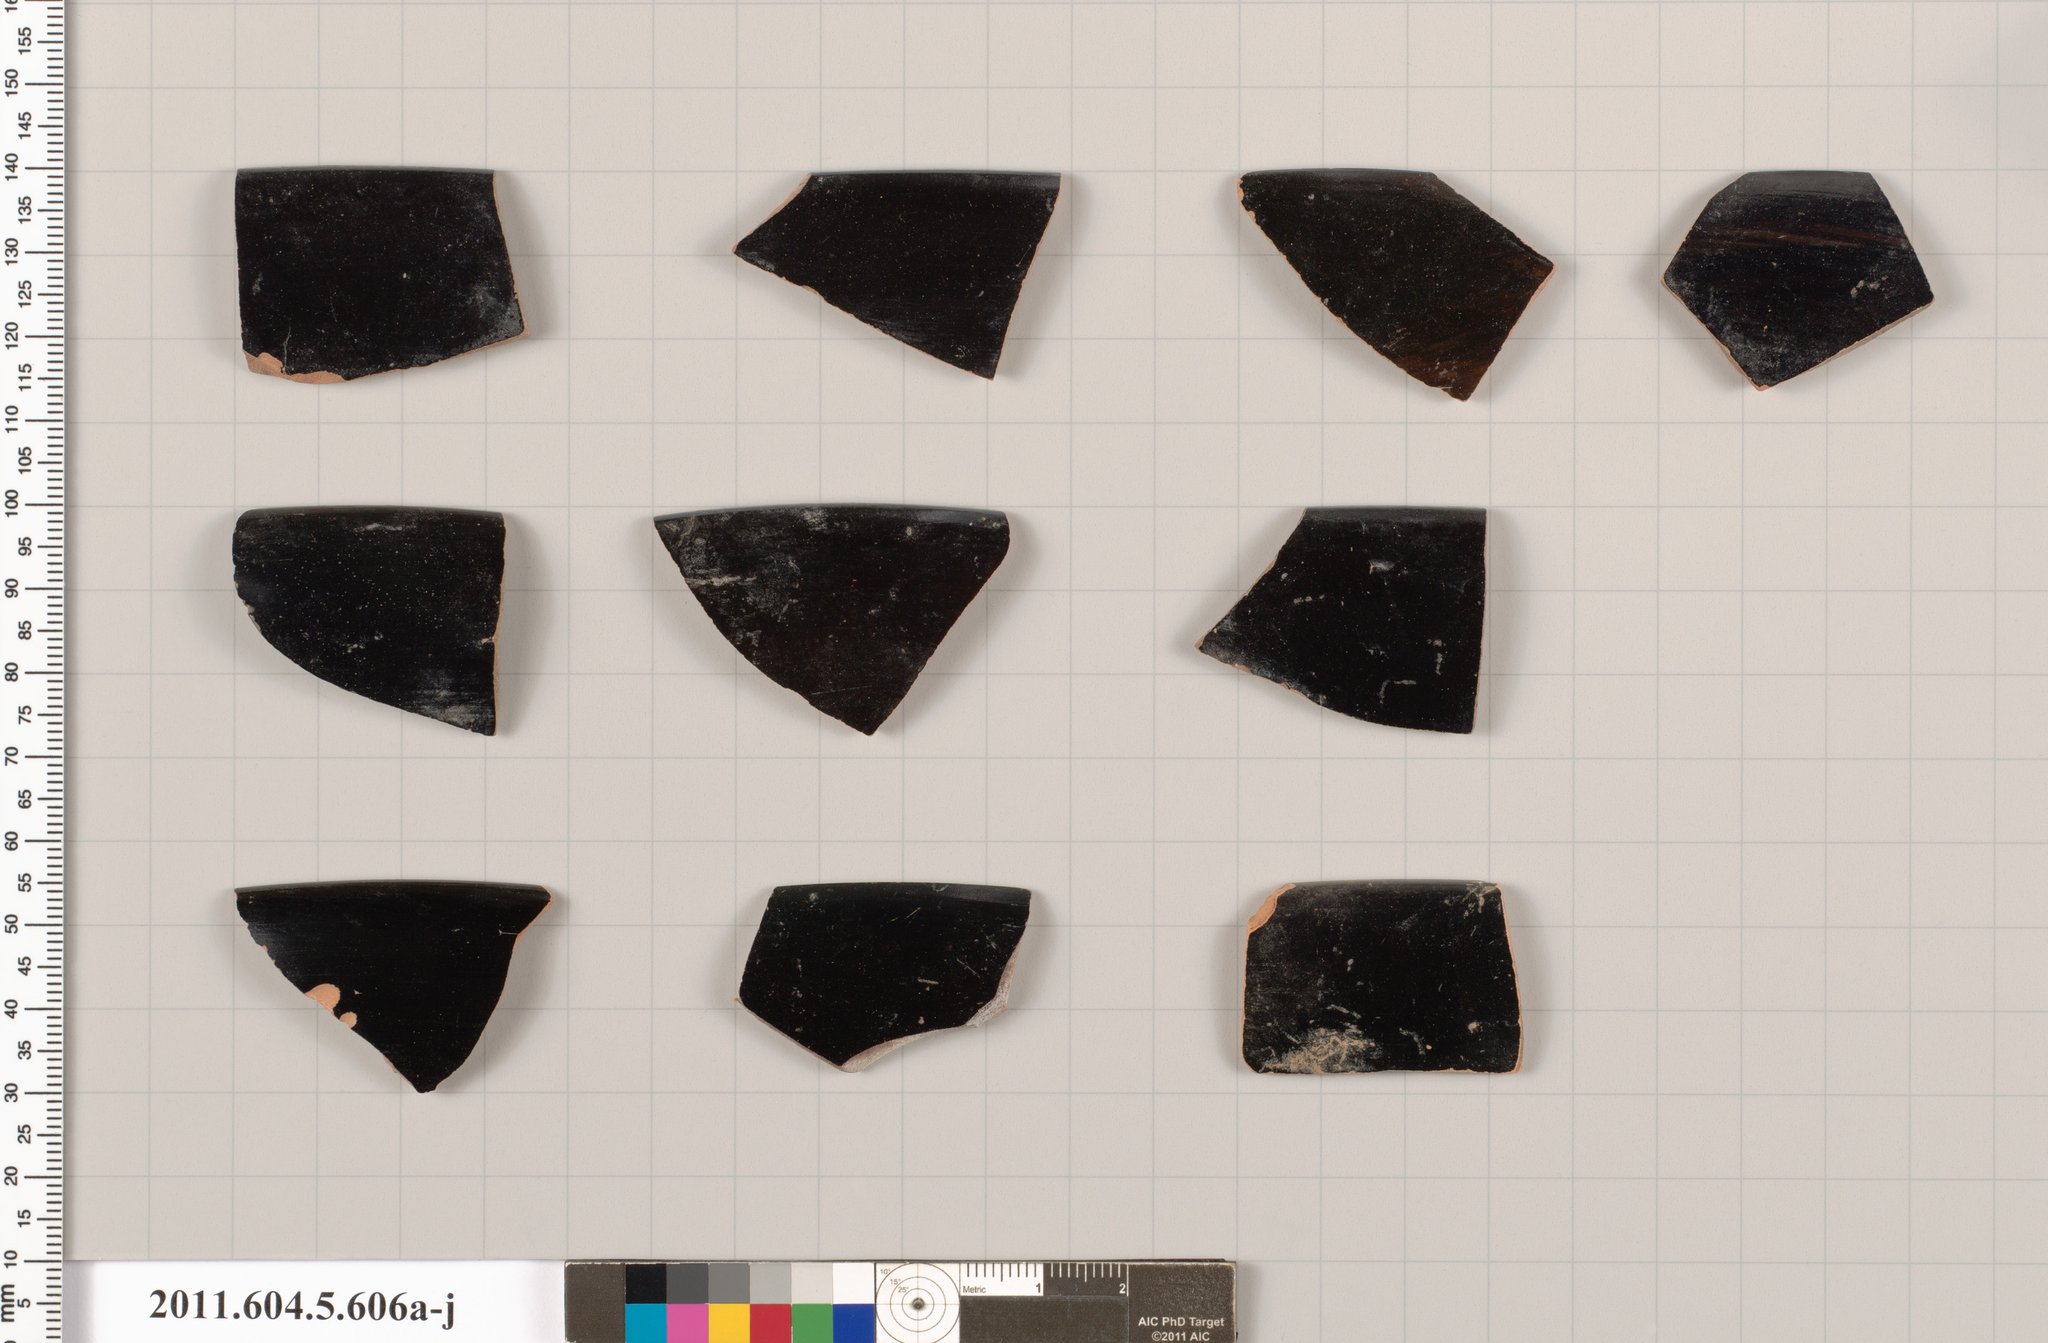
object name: kylix fragment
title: Terracotta rim fragments of kylikes (drinking cups)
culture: greek, attic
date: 600-401 BCE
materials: terracotta